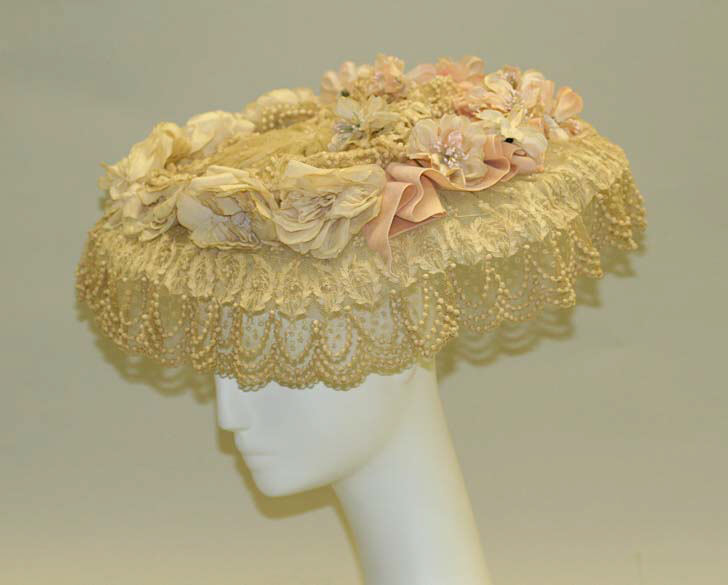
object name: hat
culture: american or european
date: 1900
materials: cotton, metal, silk